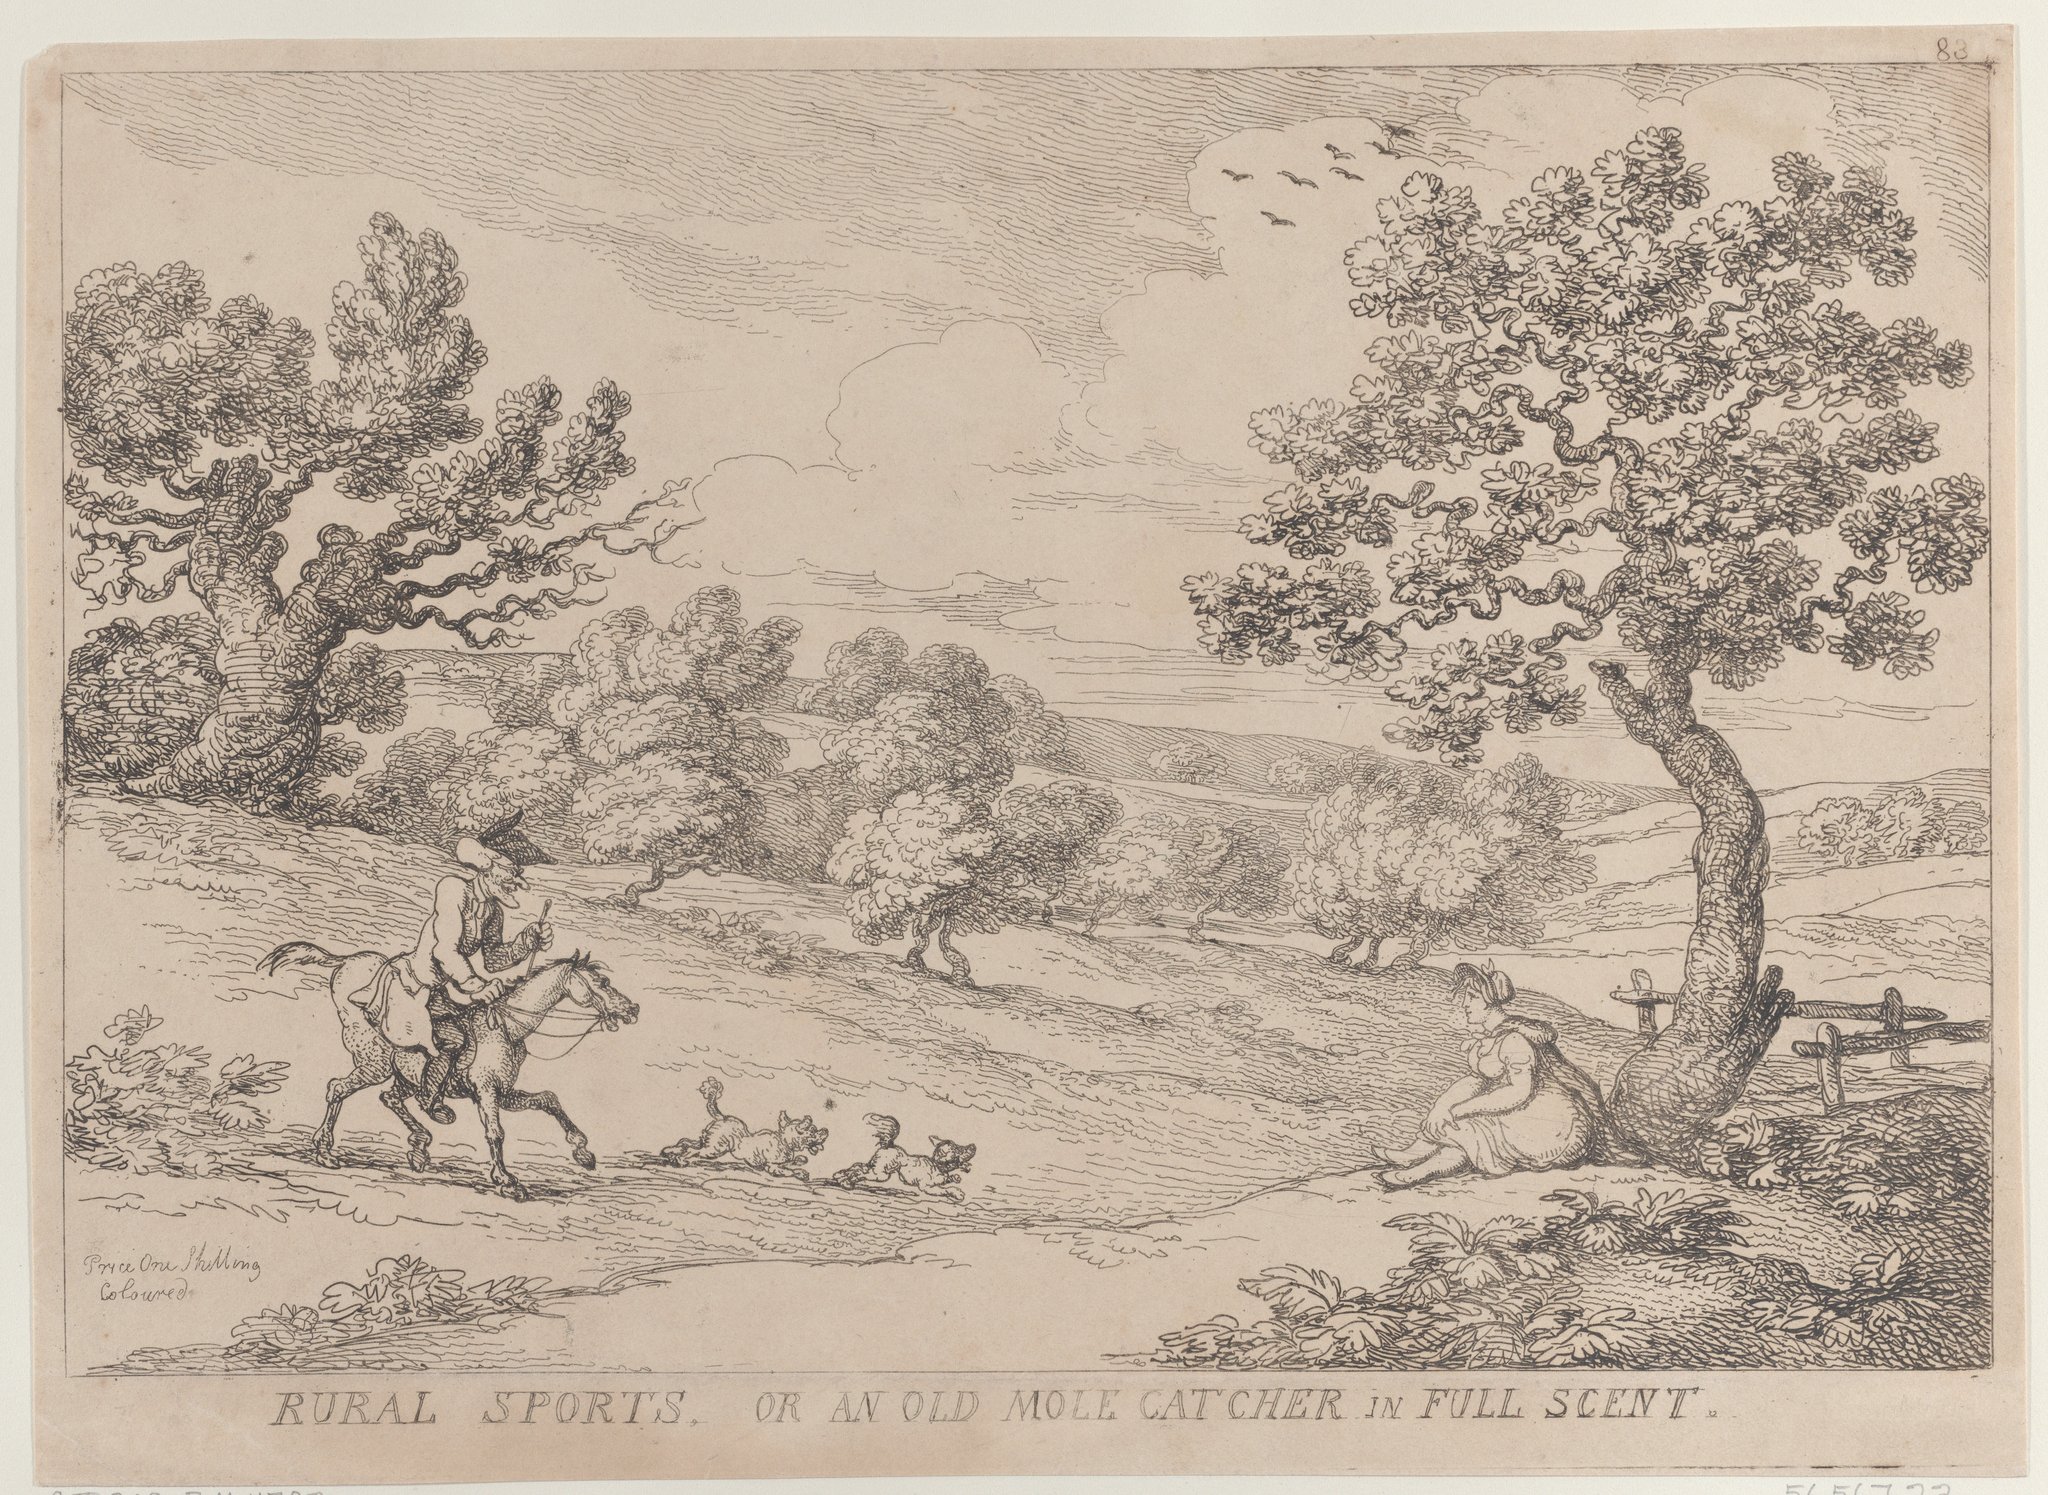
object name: print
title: Rural Sports, or an Old Mole Catcher in Full Scent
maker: thomas rowlandson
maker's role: artist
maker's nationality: british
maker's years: 1757-1827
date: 1811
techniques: etching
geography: london